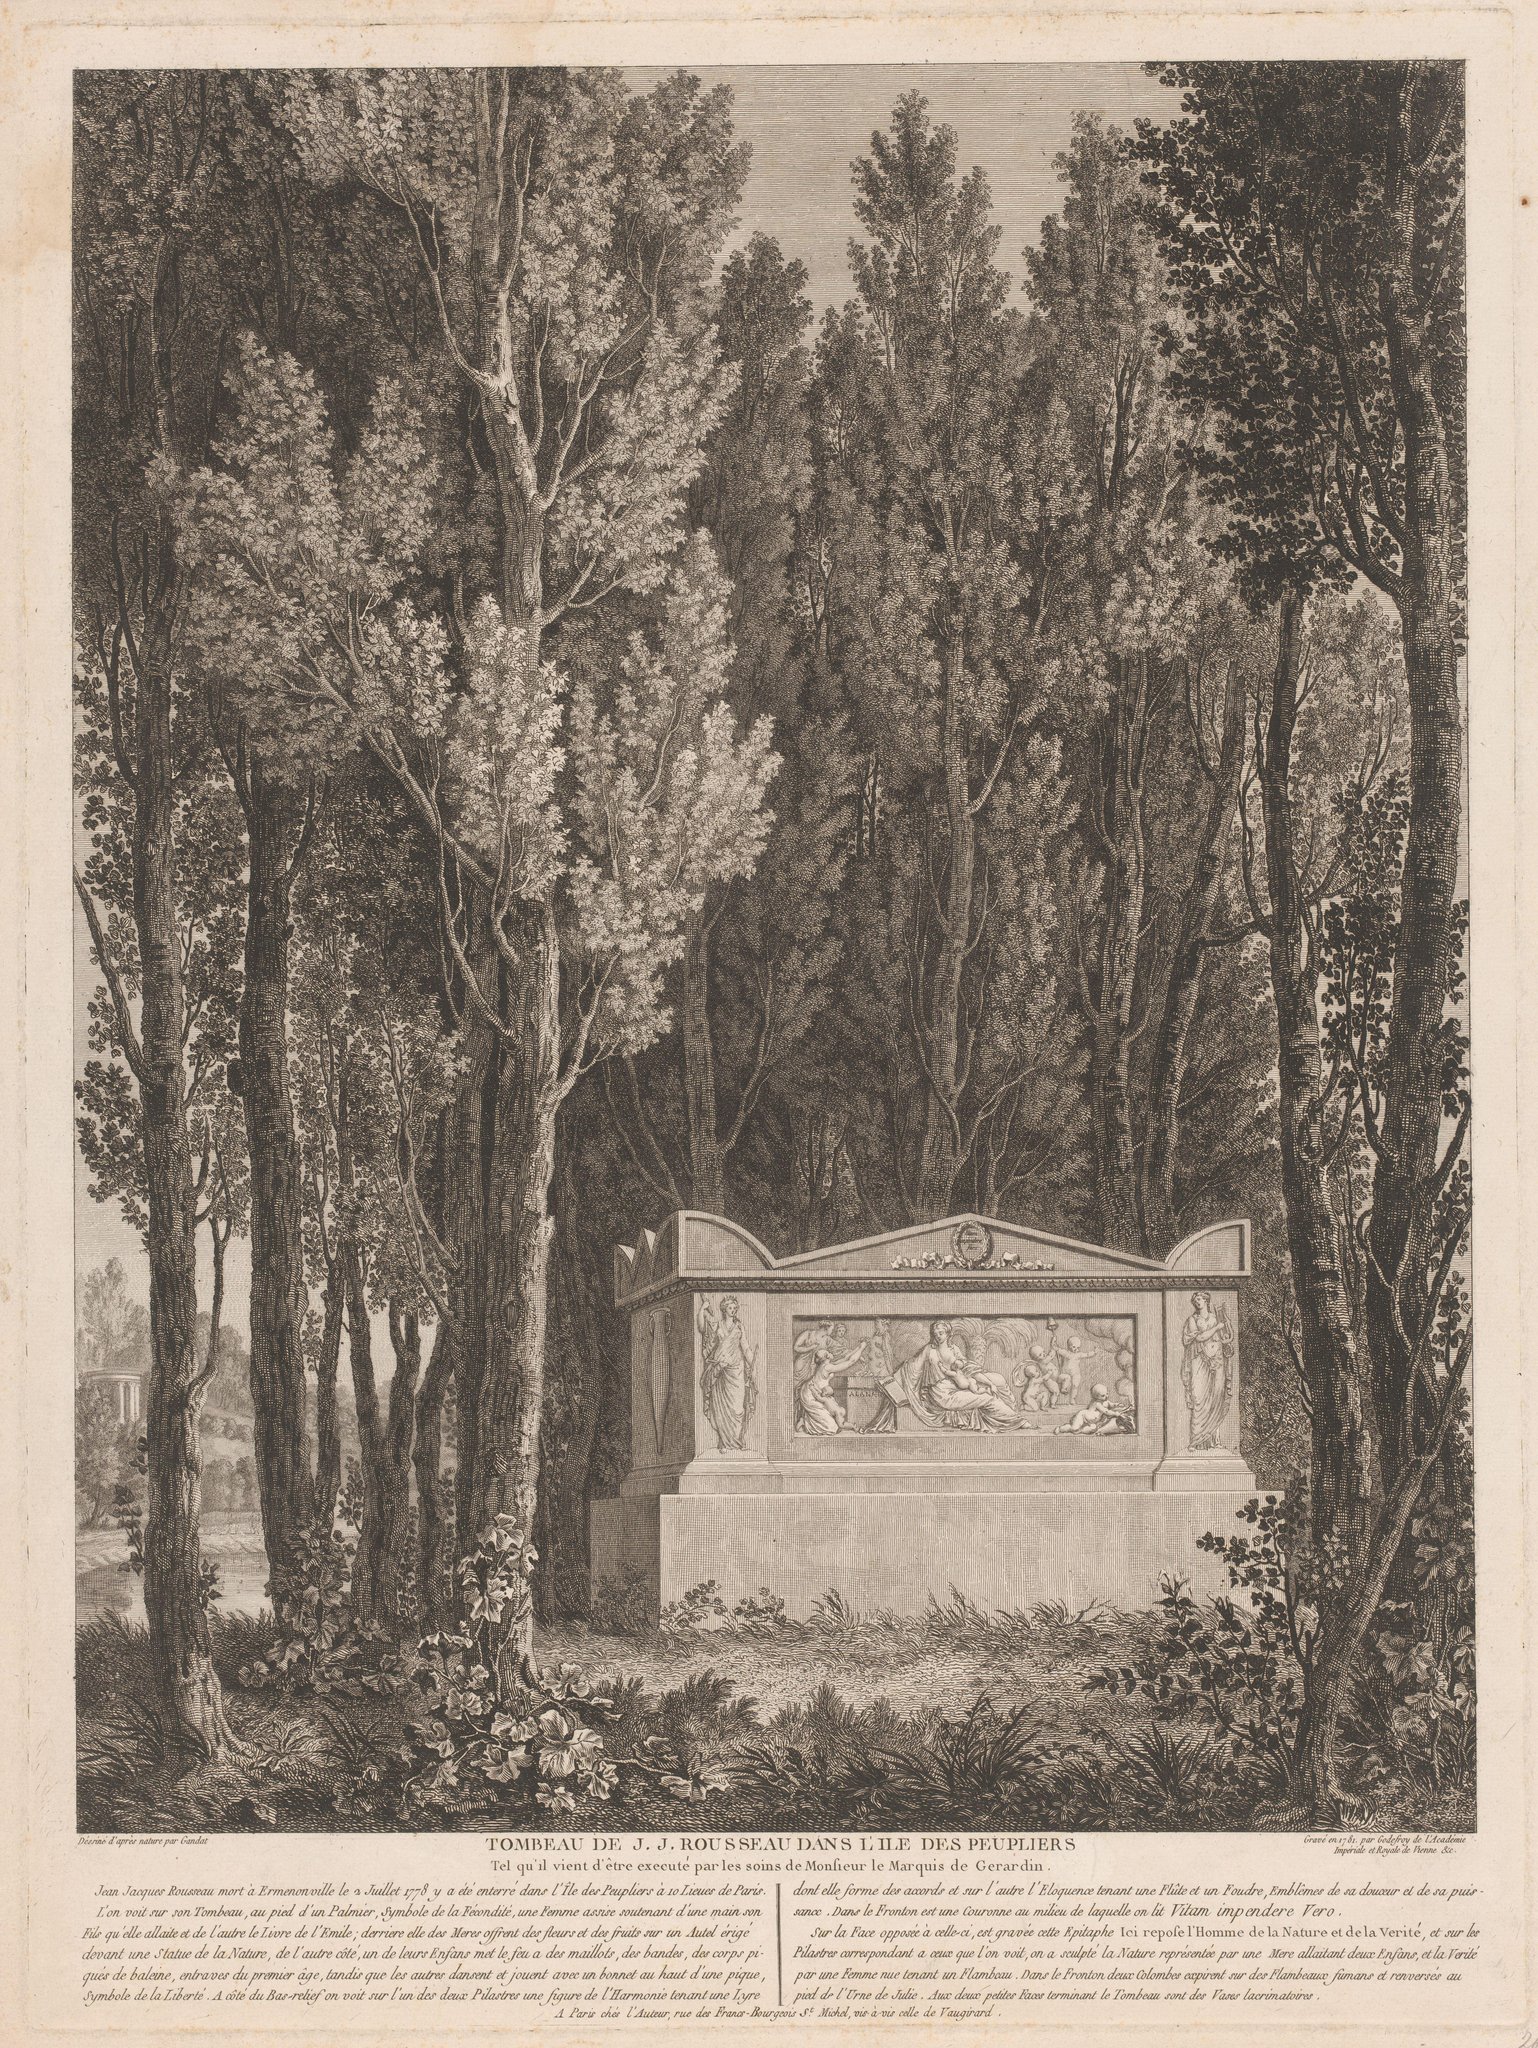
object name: print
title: Tombeau de J.J. Rousseau dans l'Ile des Peupliers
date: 1781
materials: paper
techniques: etching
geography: france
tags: island, grave, tomb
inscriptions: date